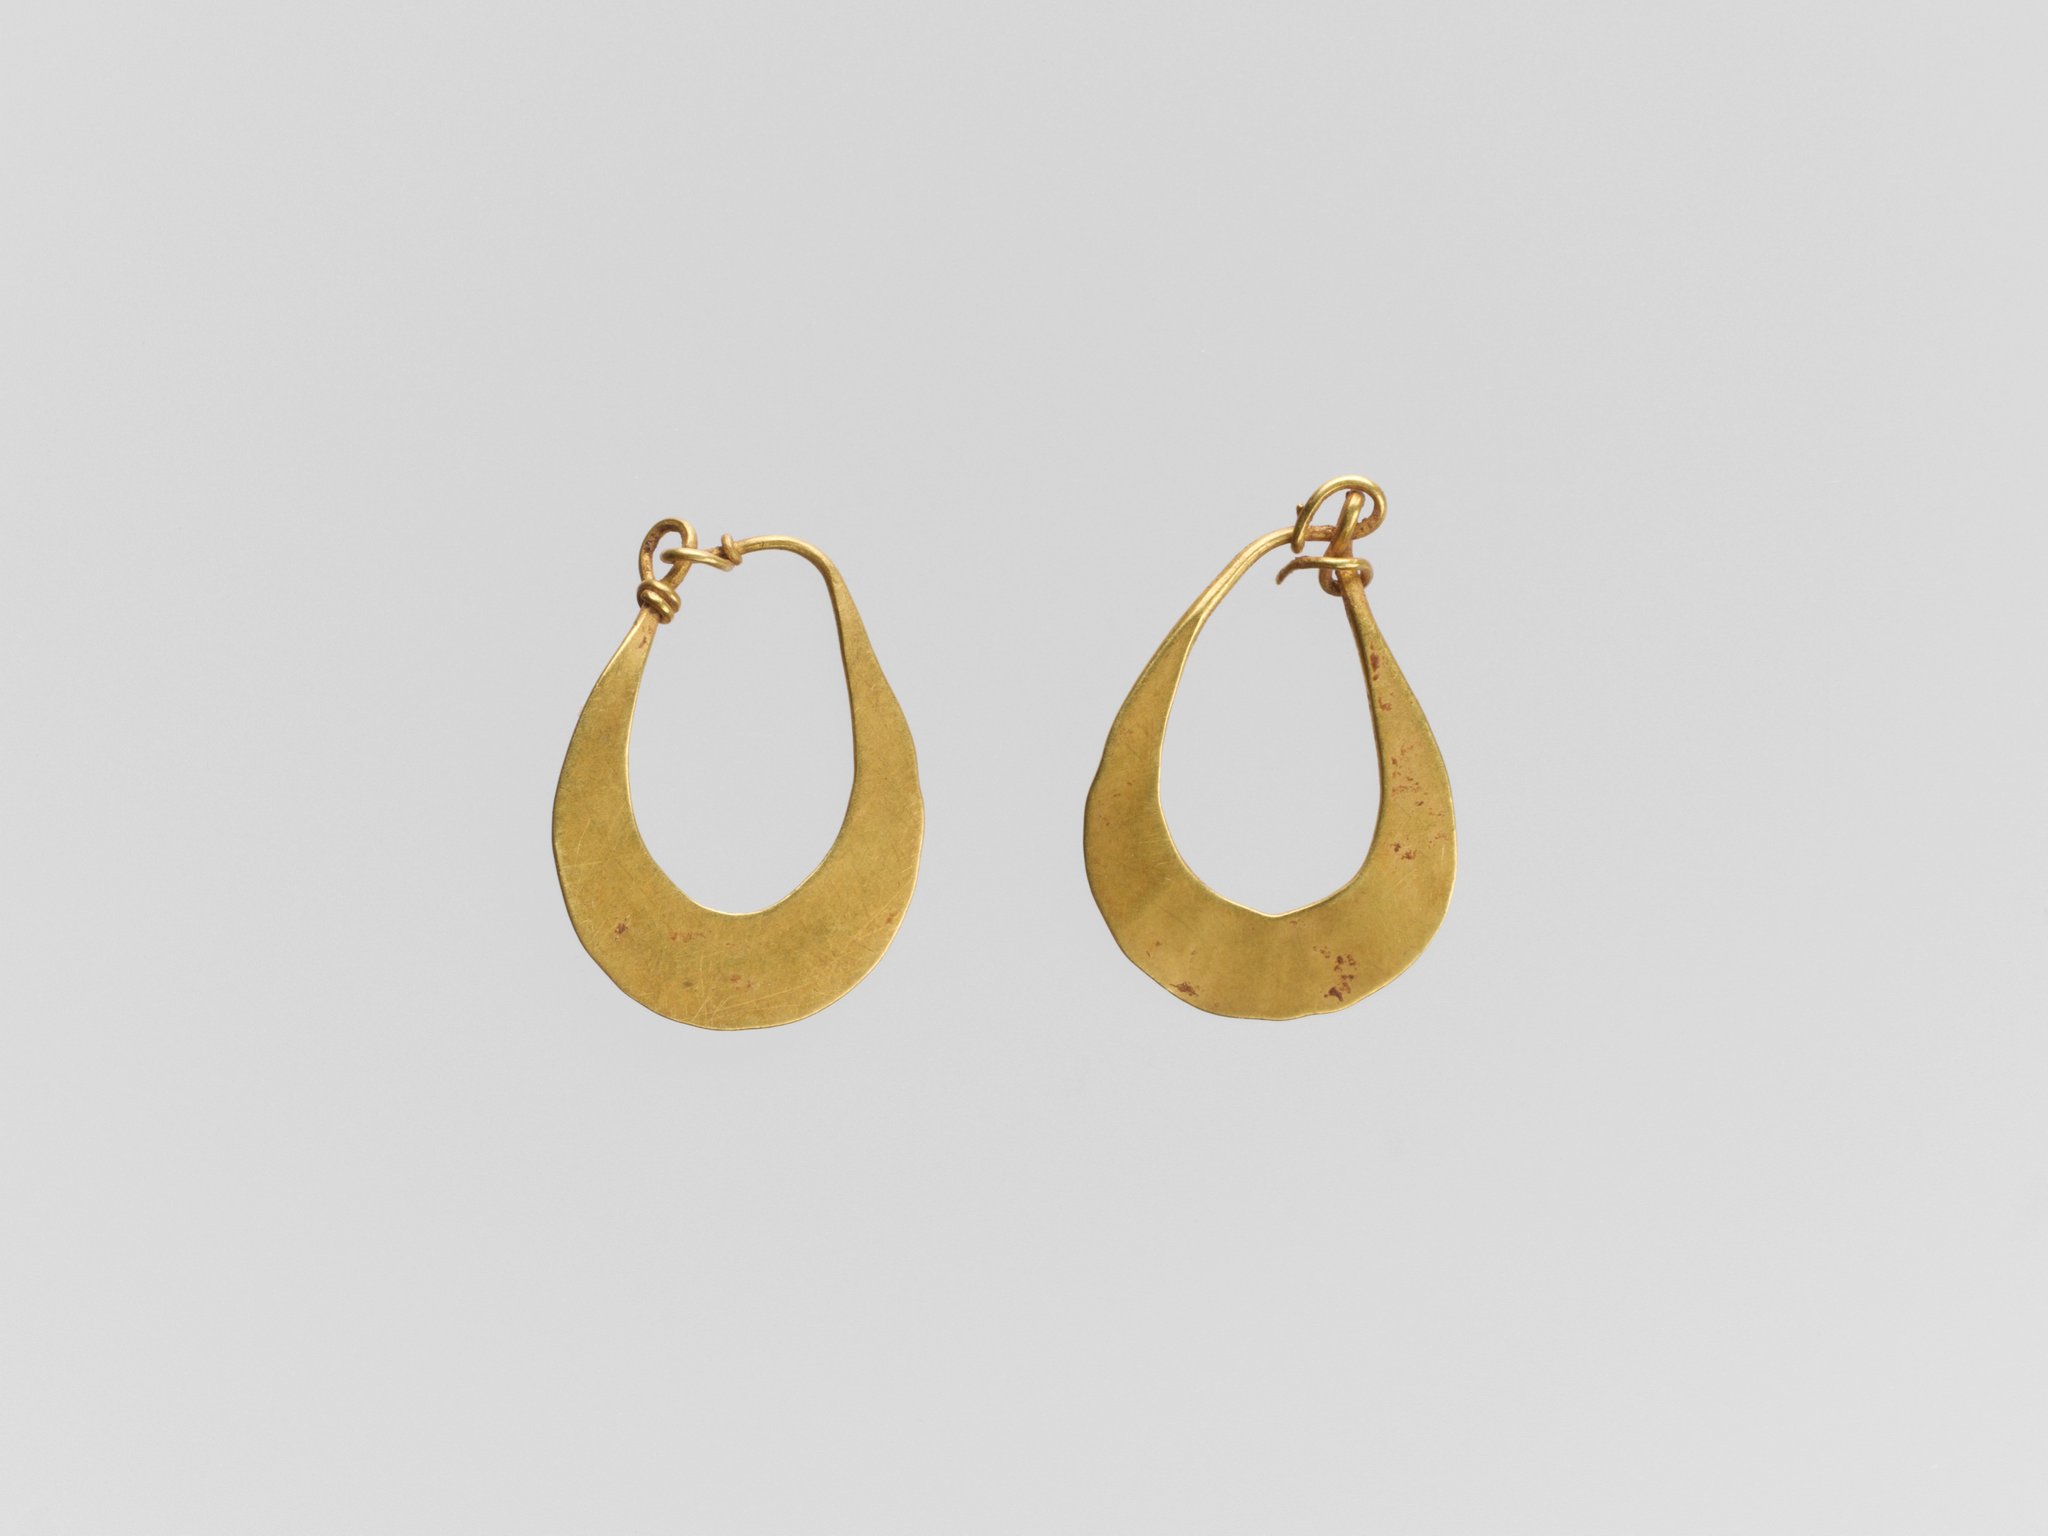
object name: earring, crescent shaped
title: Gold crescent-shaped earring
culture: cypriot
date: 500 BCE-100 CE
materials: gold